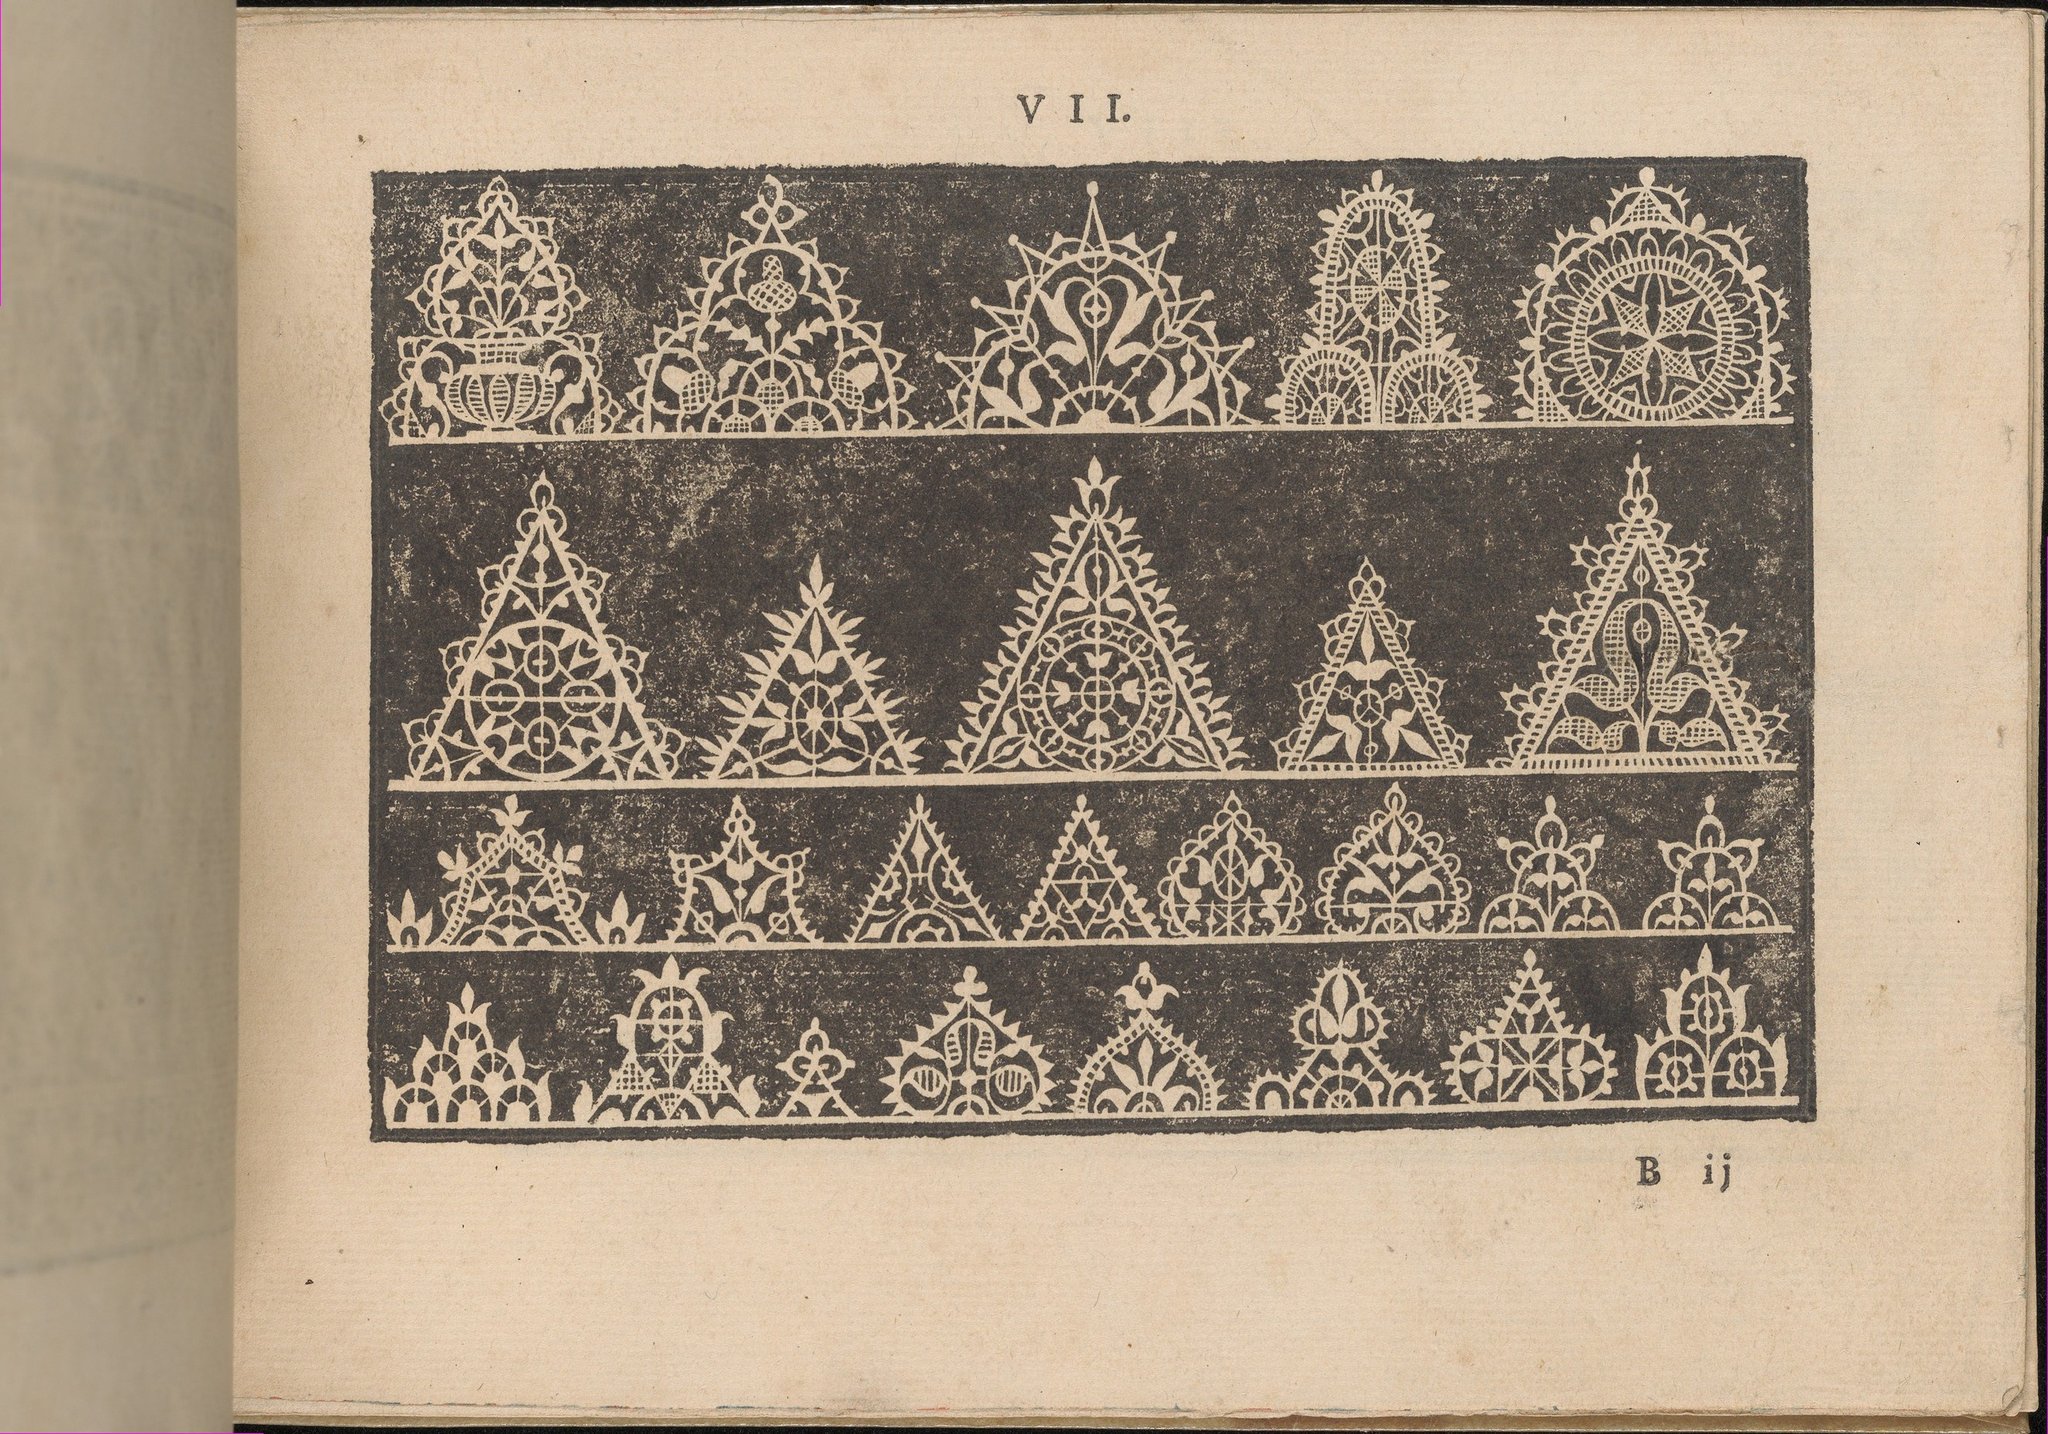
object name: book print ornament architecture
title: Prima Parte de' Fiori, e Disegni di varie sorti di Ricami Moderni, page 7 (recto)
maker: giovanni battista ciotti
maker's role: author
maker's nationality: italian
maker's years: 1555-1659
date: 1591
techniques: woodcut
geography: italy